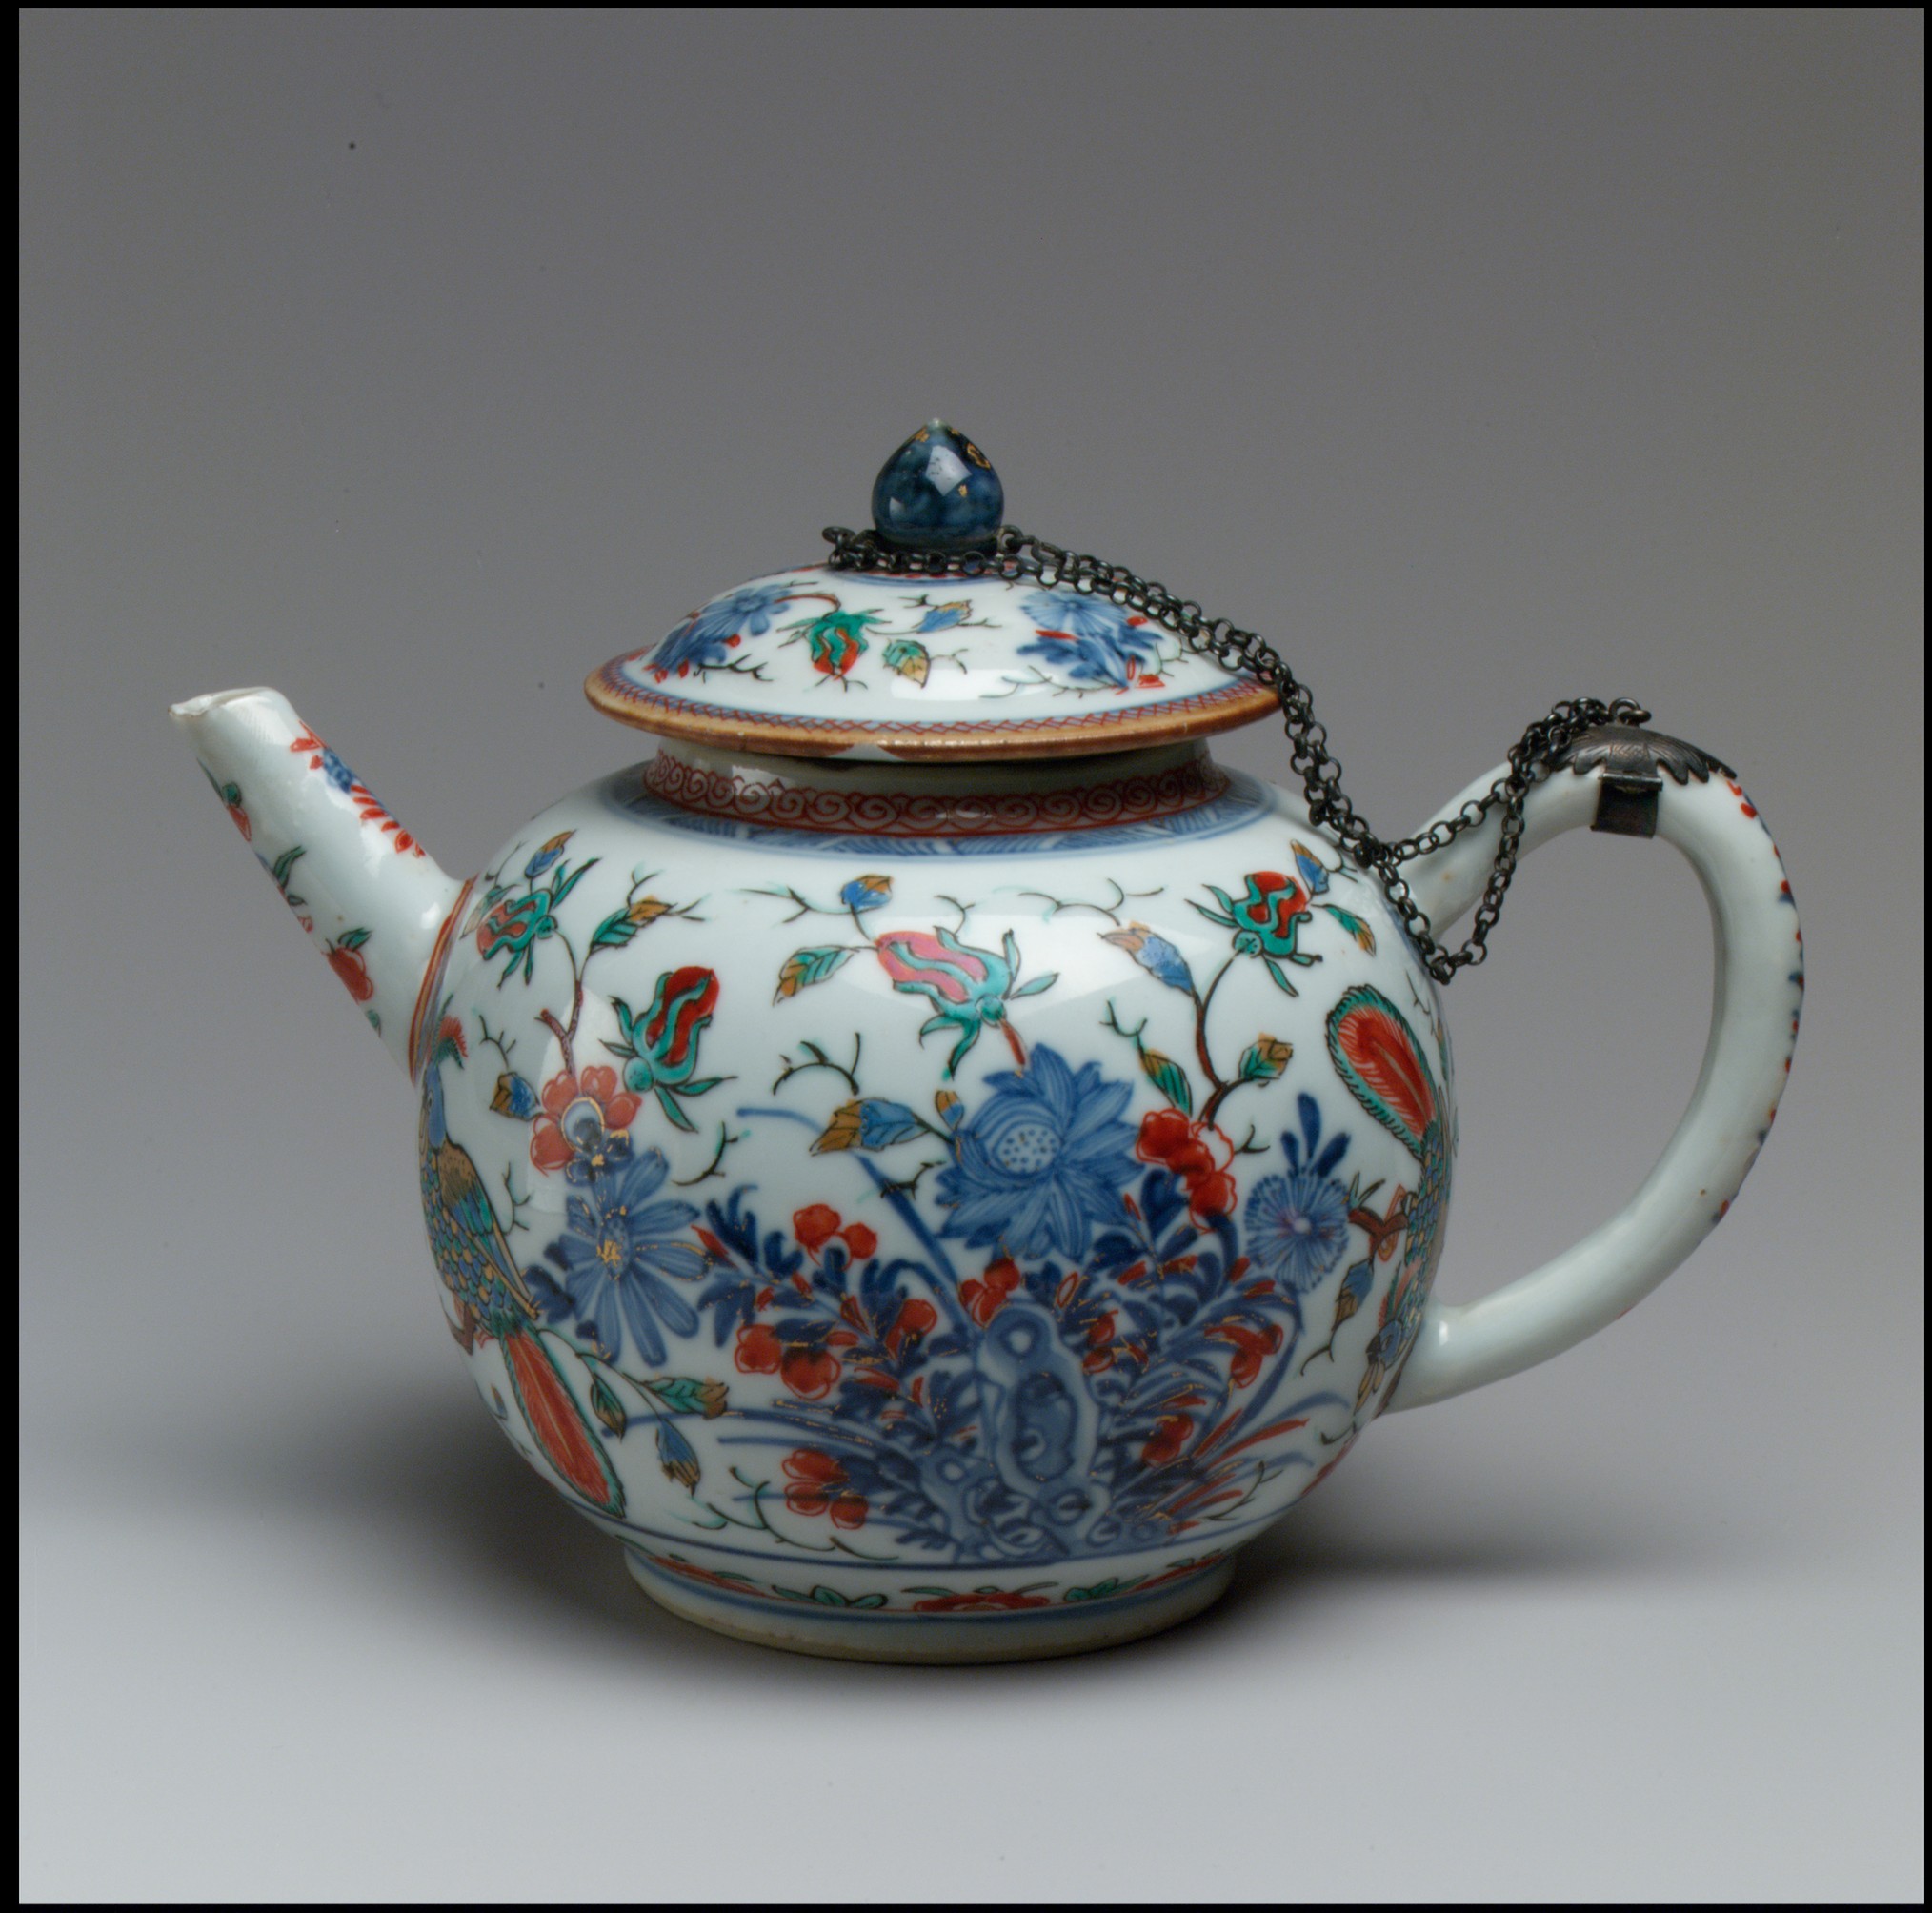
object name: teapot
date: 1701-1800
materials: hard paste porcelain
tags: flowers